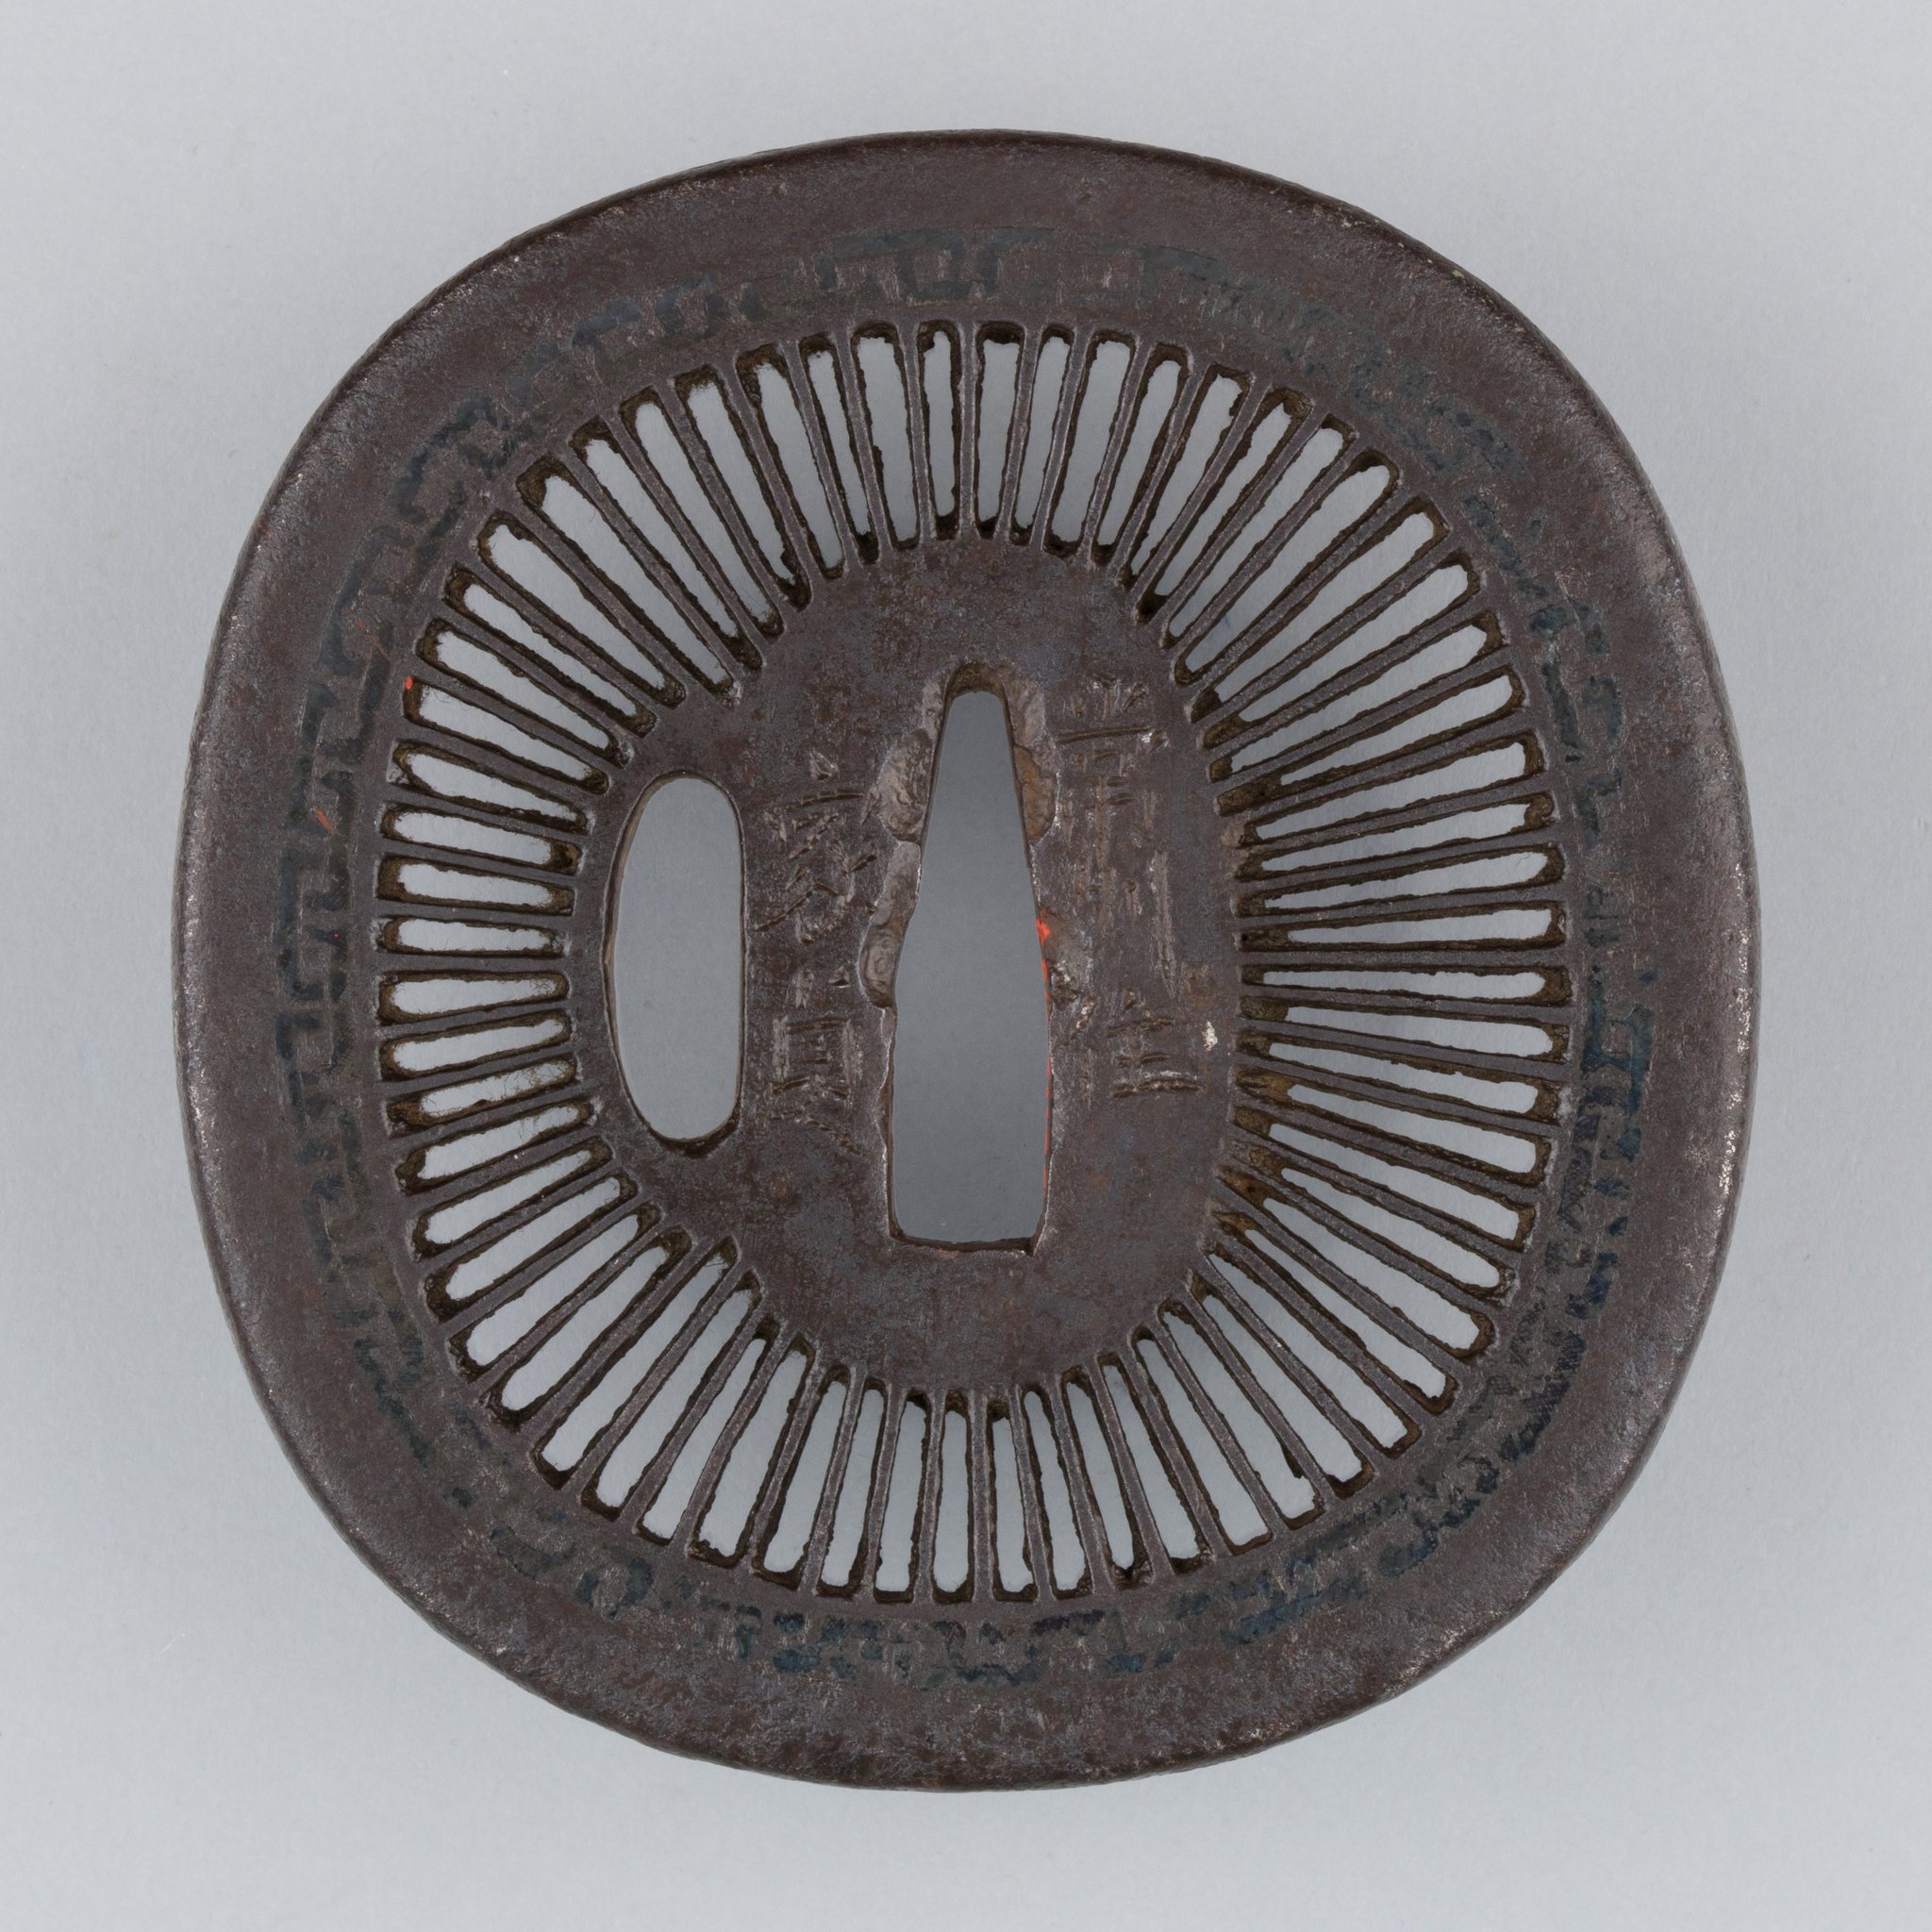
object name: sword guard tsuba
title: Sword Guard (Tsuba)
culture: japanese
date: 1690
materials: copper, iron, silver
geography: japan